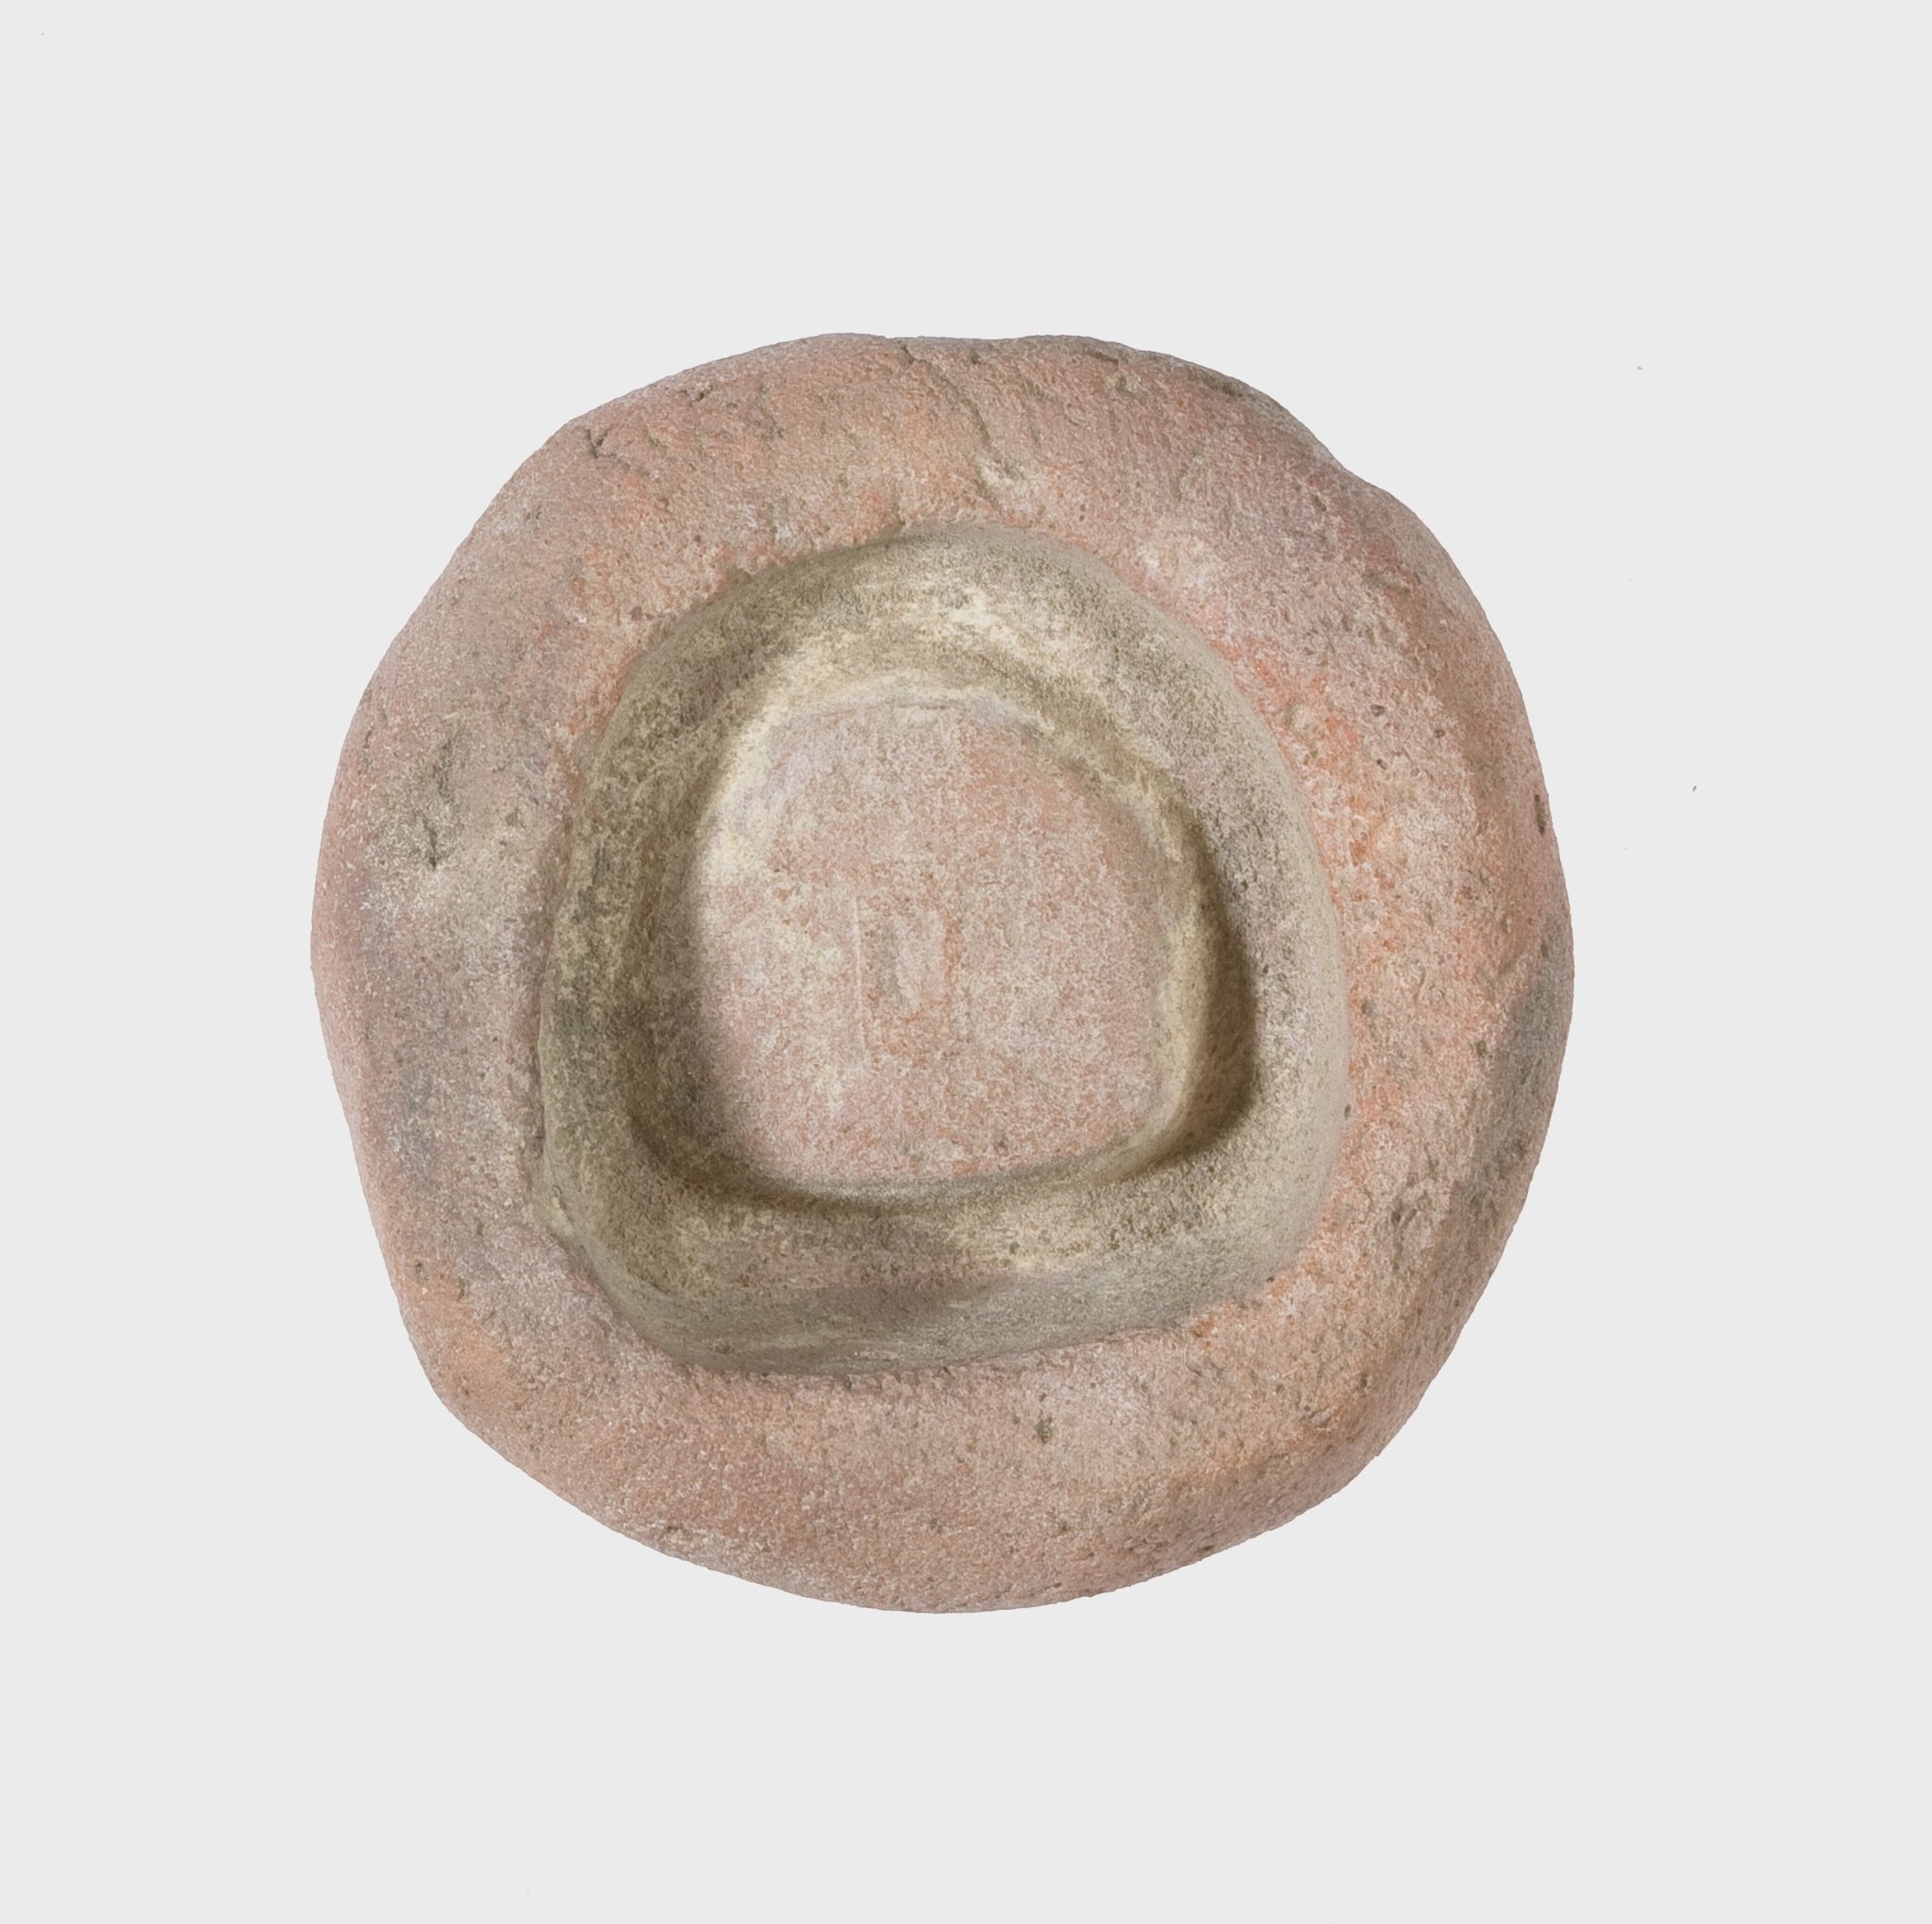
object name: mold, ring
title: Mold for a Ring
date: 1390-1352 BCE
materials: pottery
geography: egypt